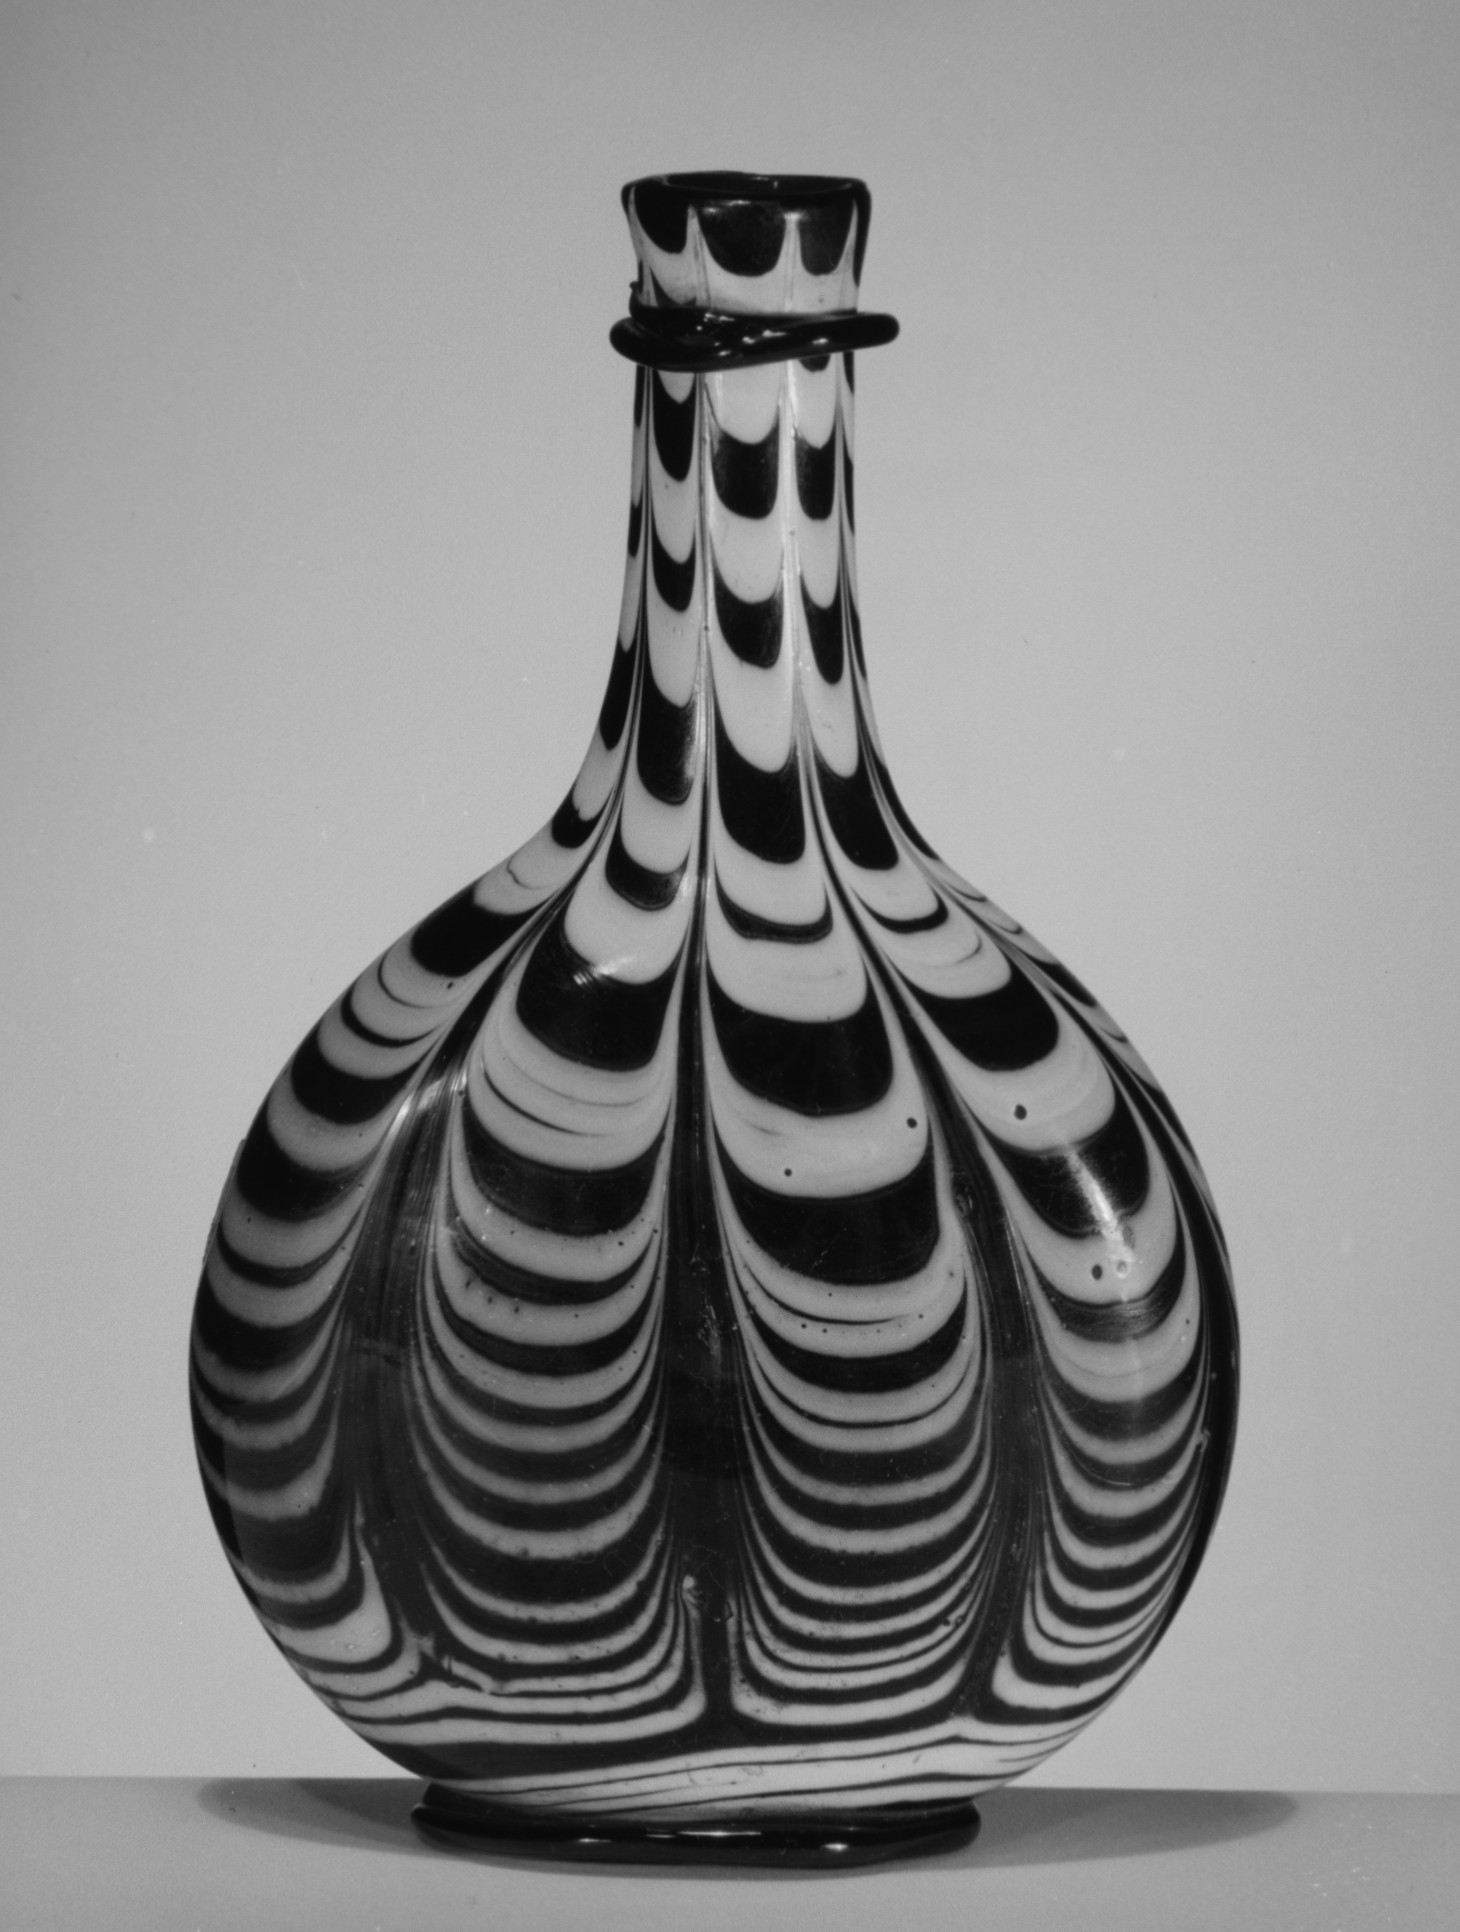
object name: bottle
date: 1701-1800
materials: glass